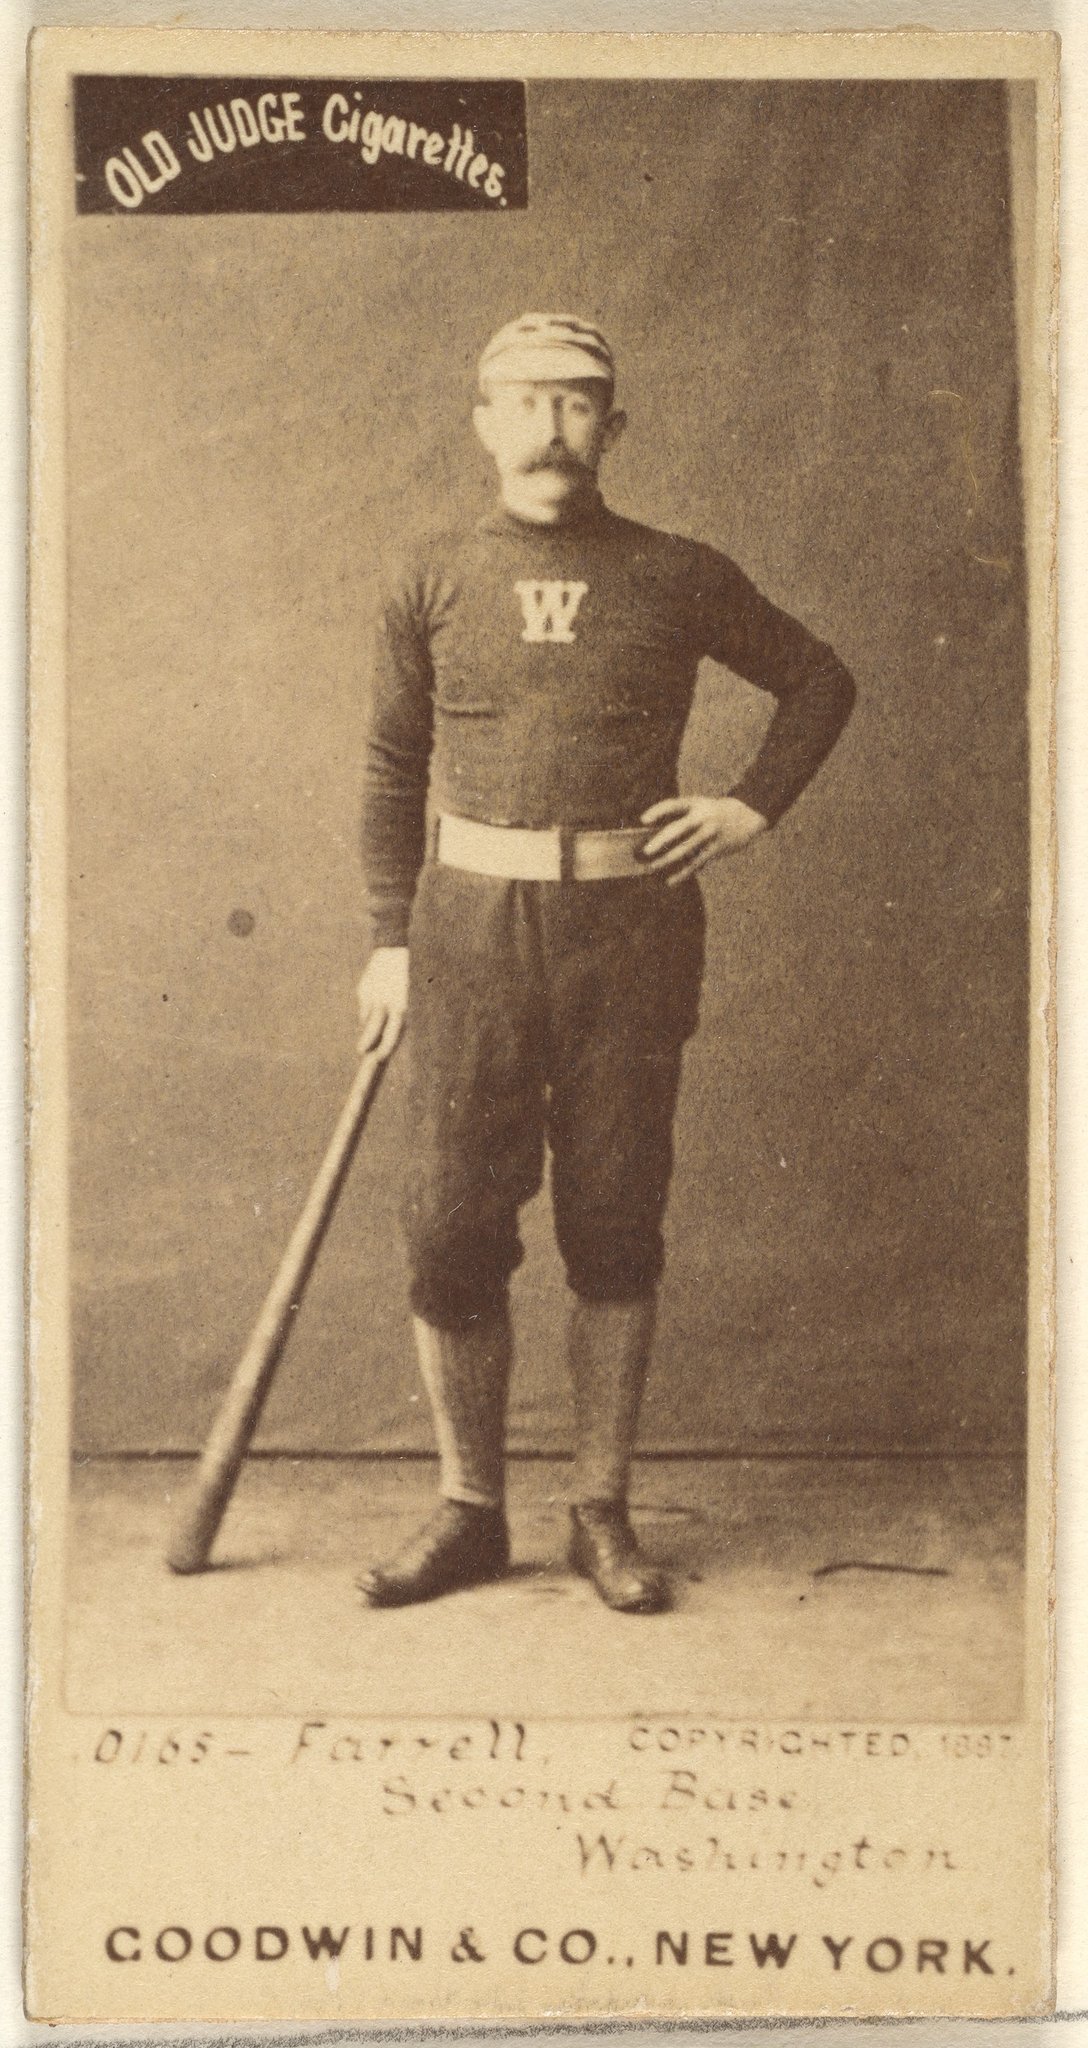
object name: baseball card, photograph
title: John A. "Jack" Farrell, 2nd Base, Washington Nationals, from the Old Judge series (N172) for Old Judge Cigarettes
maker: goodwin & company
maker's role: publisher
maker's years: 1850-1950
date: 1887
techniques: albumen silver print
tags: men,portraits,baseball,athletes